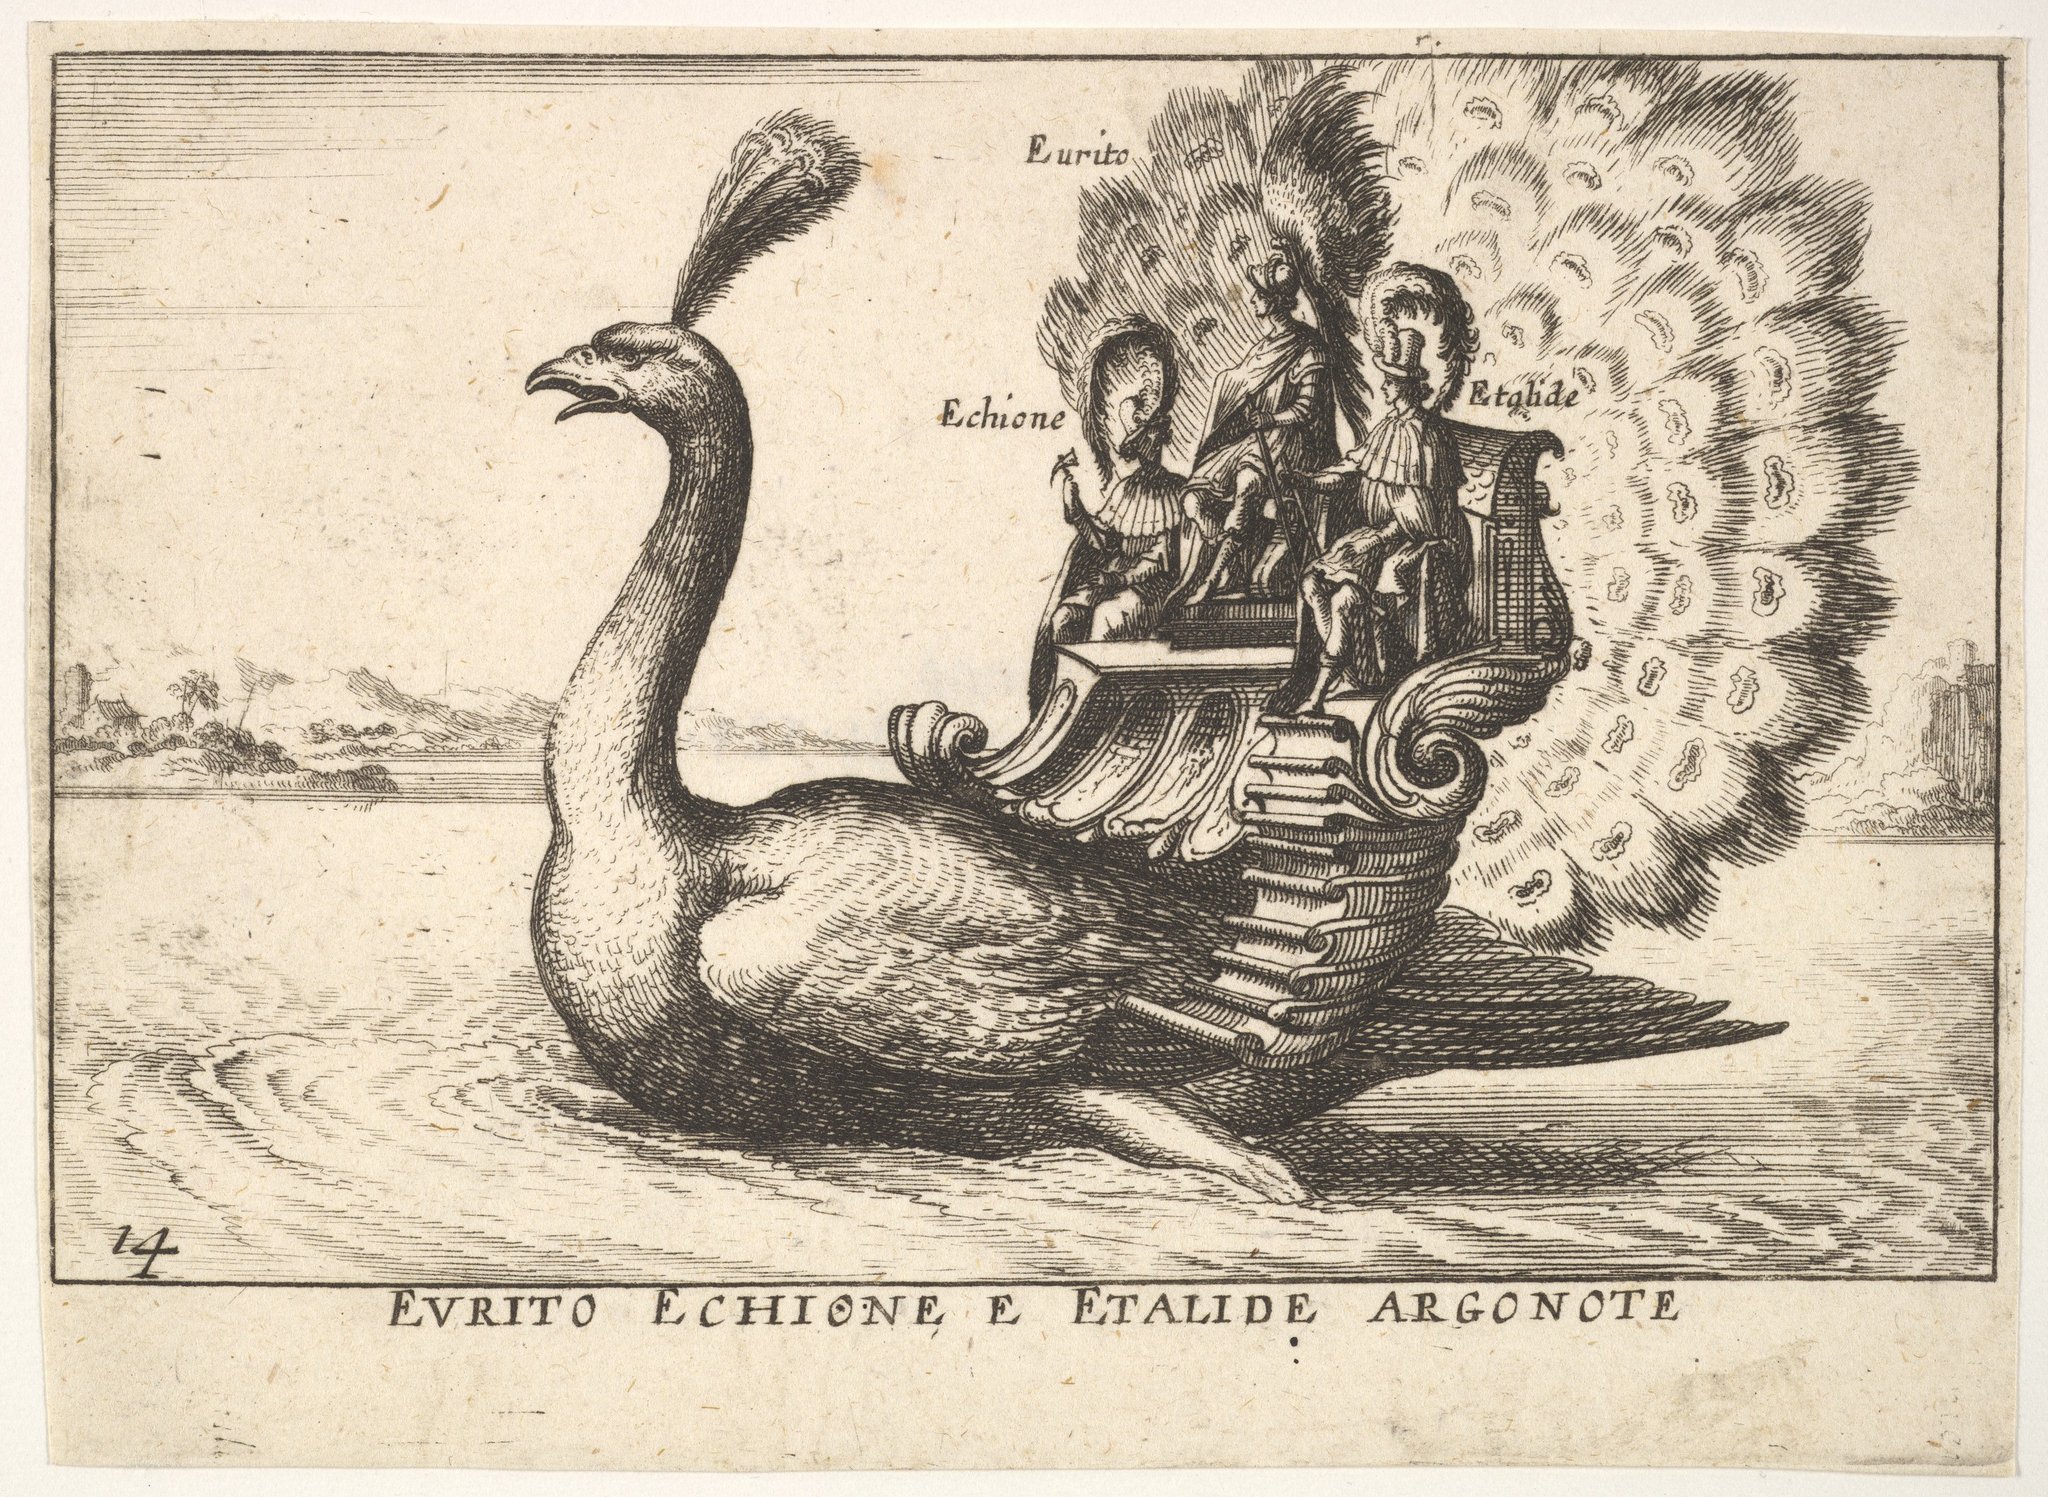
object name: print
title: Plate 14: The Argonauts Eurytus, Echion, and Aethalides (Eurito Echione e Etalide Argonote), led by Mercury in the form of a peacock, from "The magnificent pageant on the river Arno in Florence for the marriage of the Grand Duke" (Le Magnifique carousel fait sur le fleuve de l'Arne a Florence, pour le mariage du Grand Duc)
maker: Anonymous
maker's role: artist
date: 1664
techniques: etching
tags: argonauts,mercury,peacocks,rivers